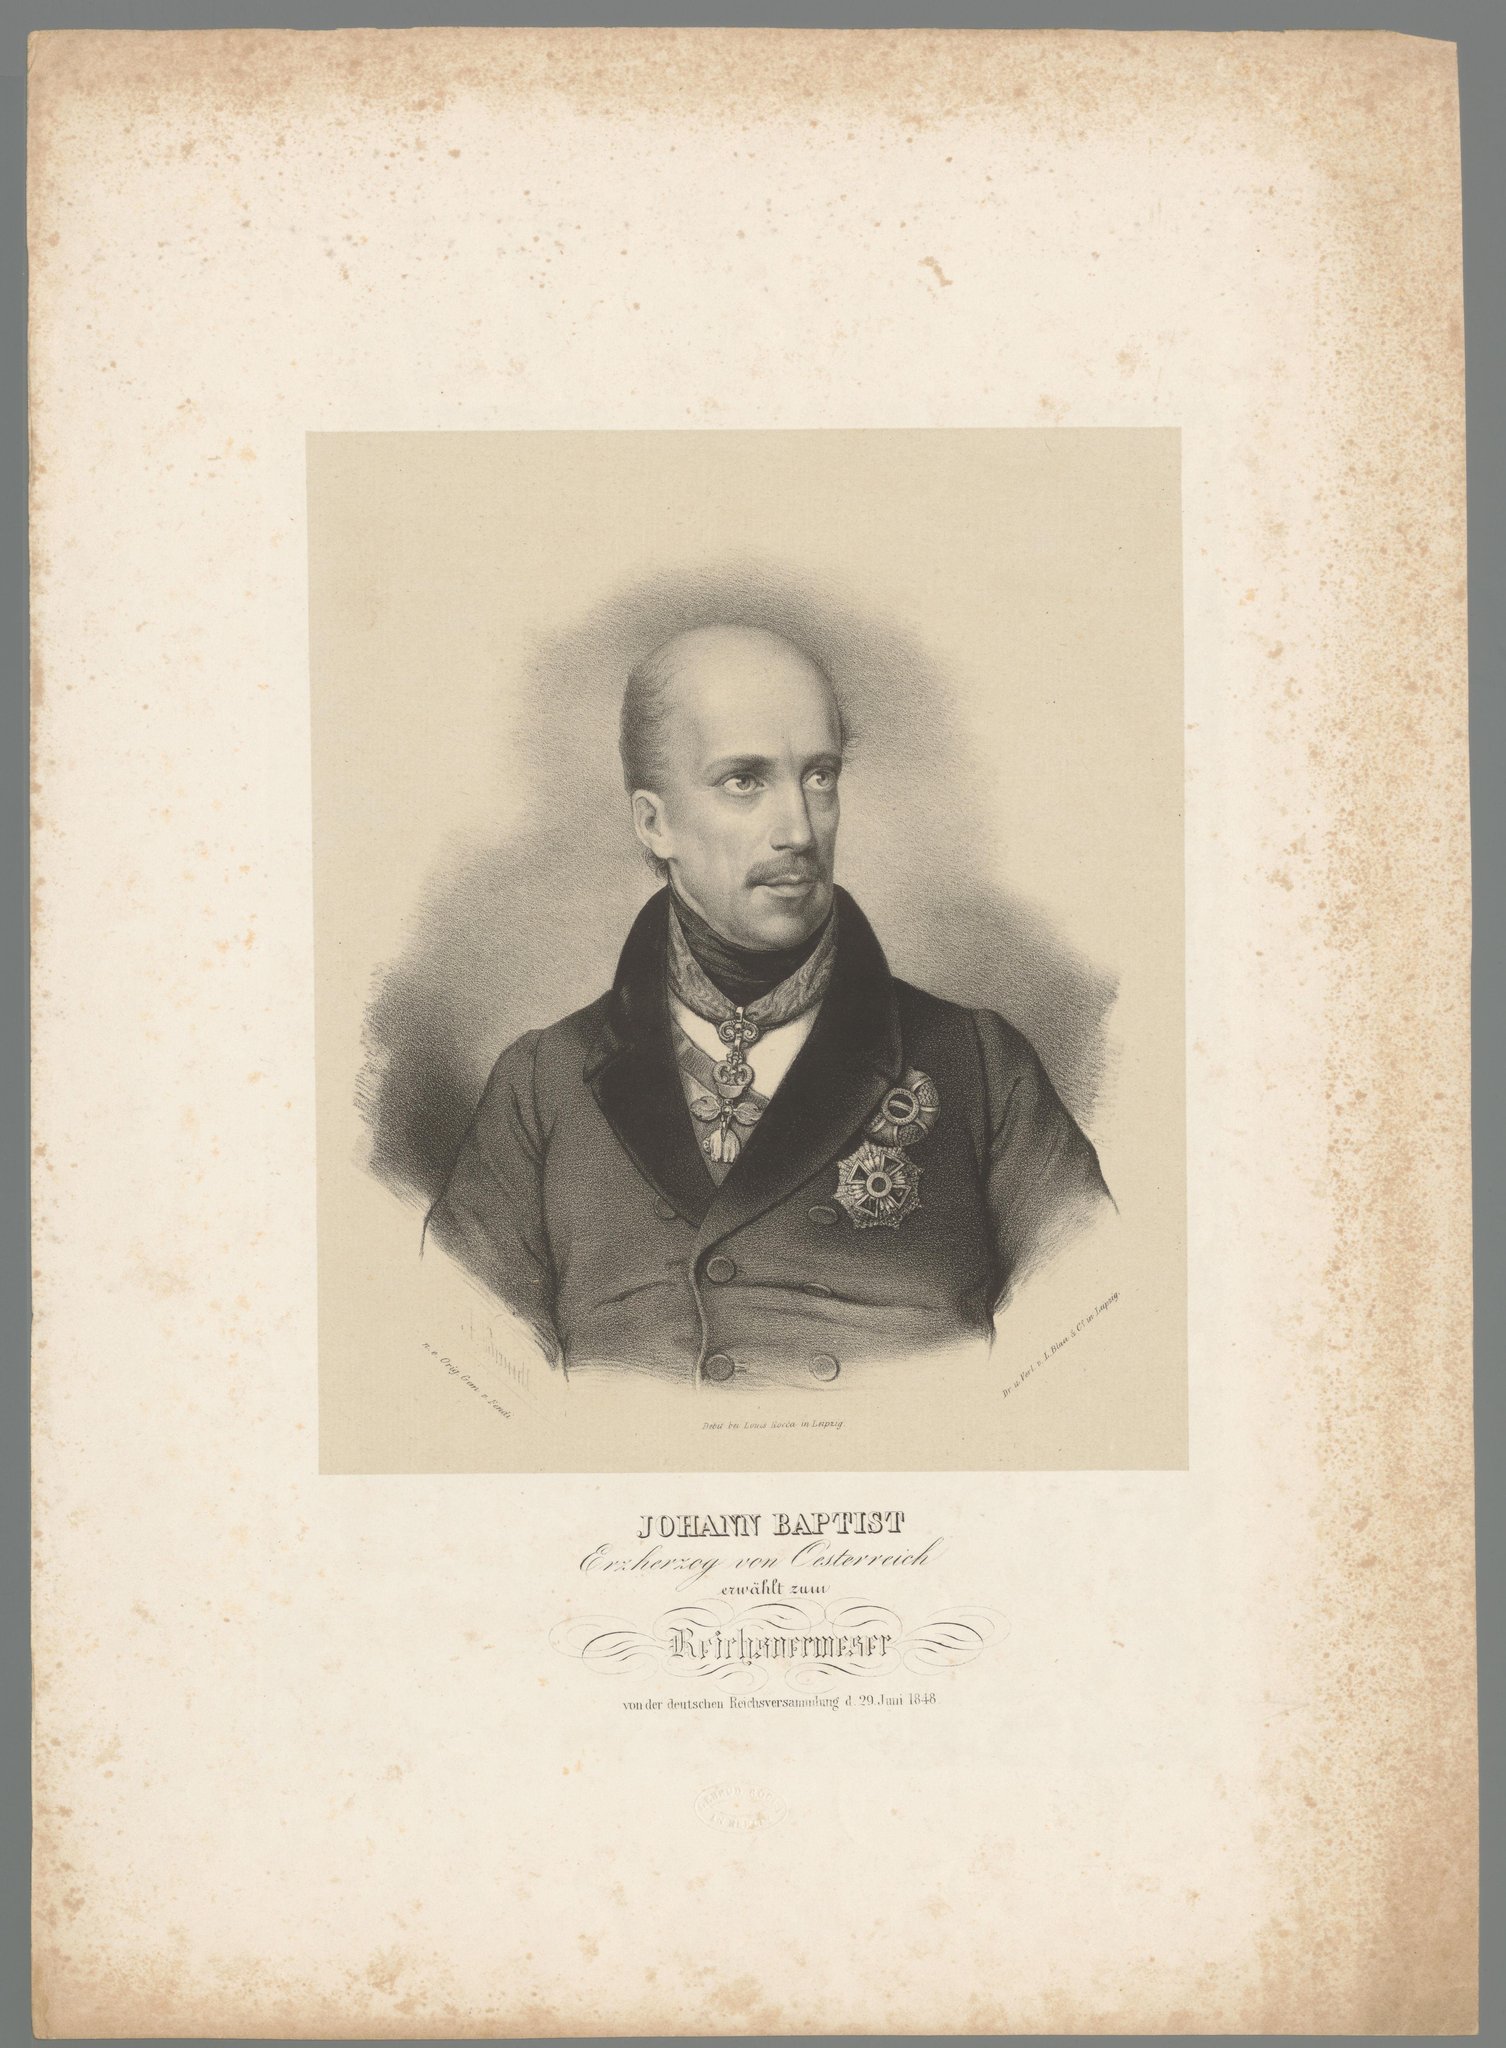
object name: print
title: Johann Baptist Erzherzog von Oesterreich erwählt zum Reichsverweser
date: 1848-1850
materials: paper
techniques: lithograph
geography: berlin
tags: adult man, historical persons, knighthood order of the golden fleece - insignia of a knighthood order, e.g.: badge, chain (with name of order)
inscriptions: collector's mark: Lugt 2228, check stamp: Lugt 2141c